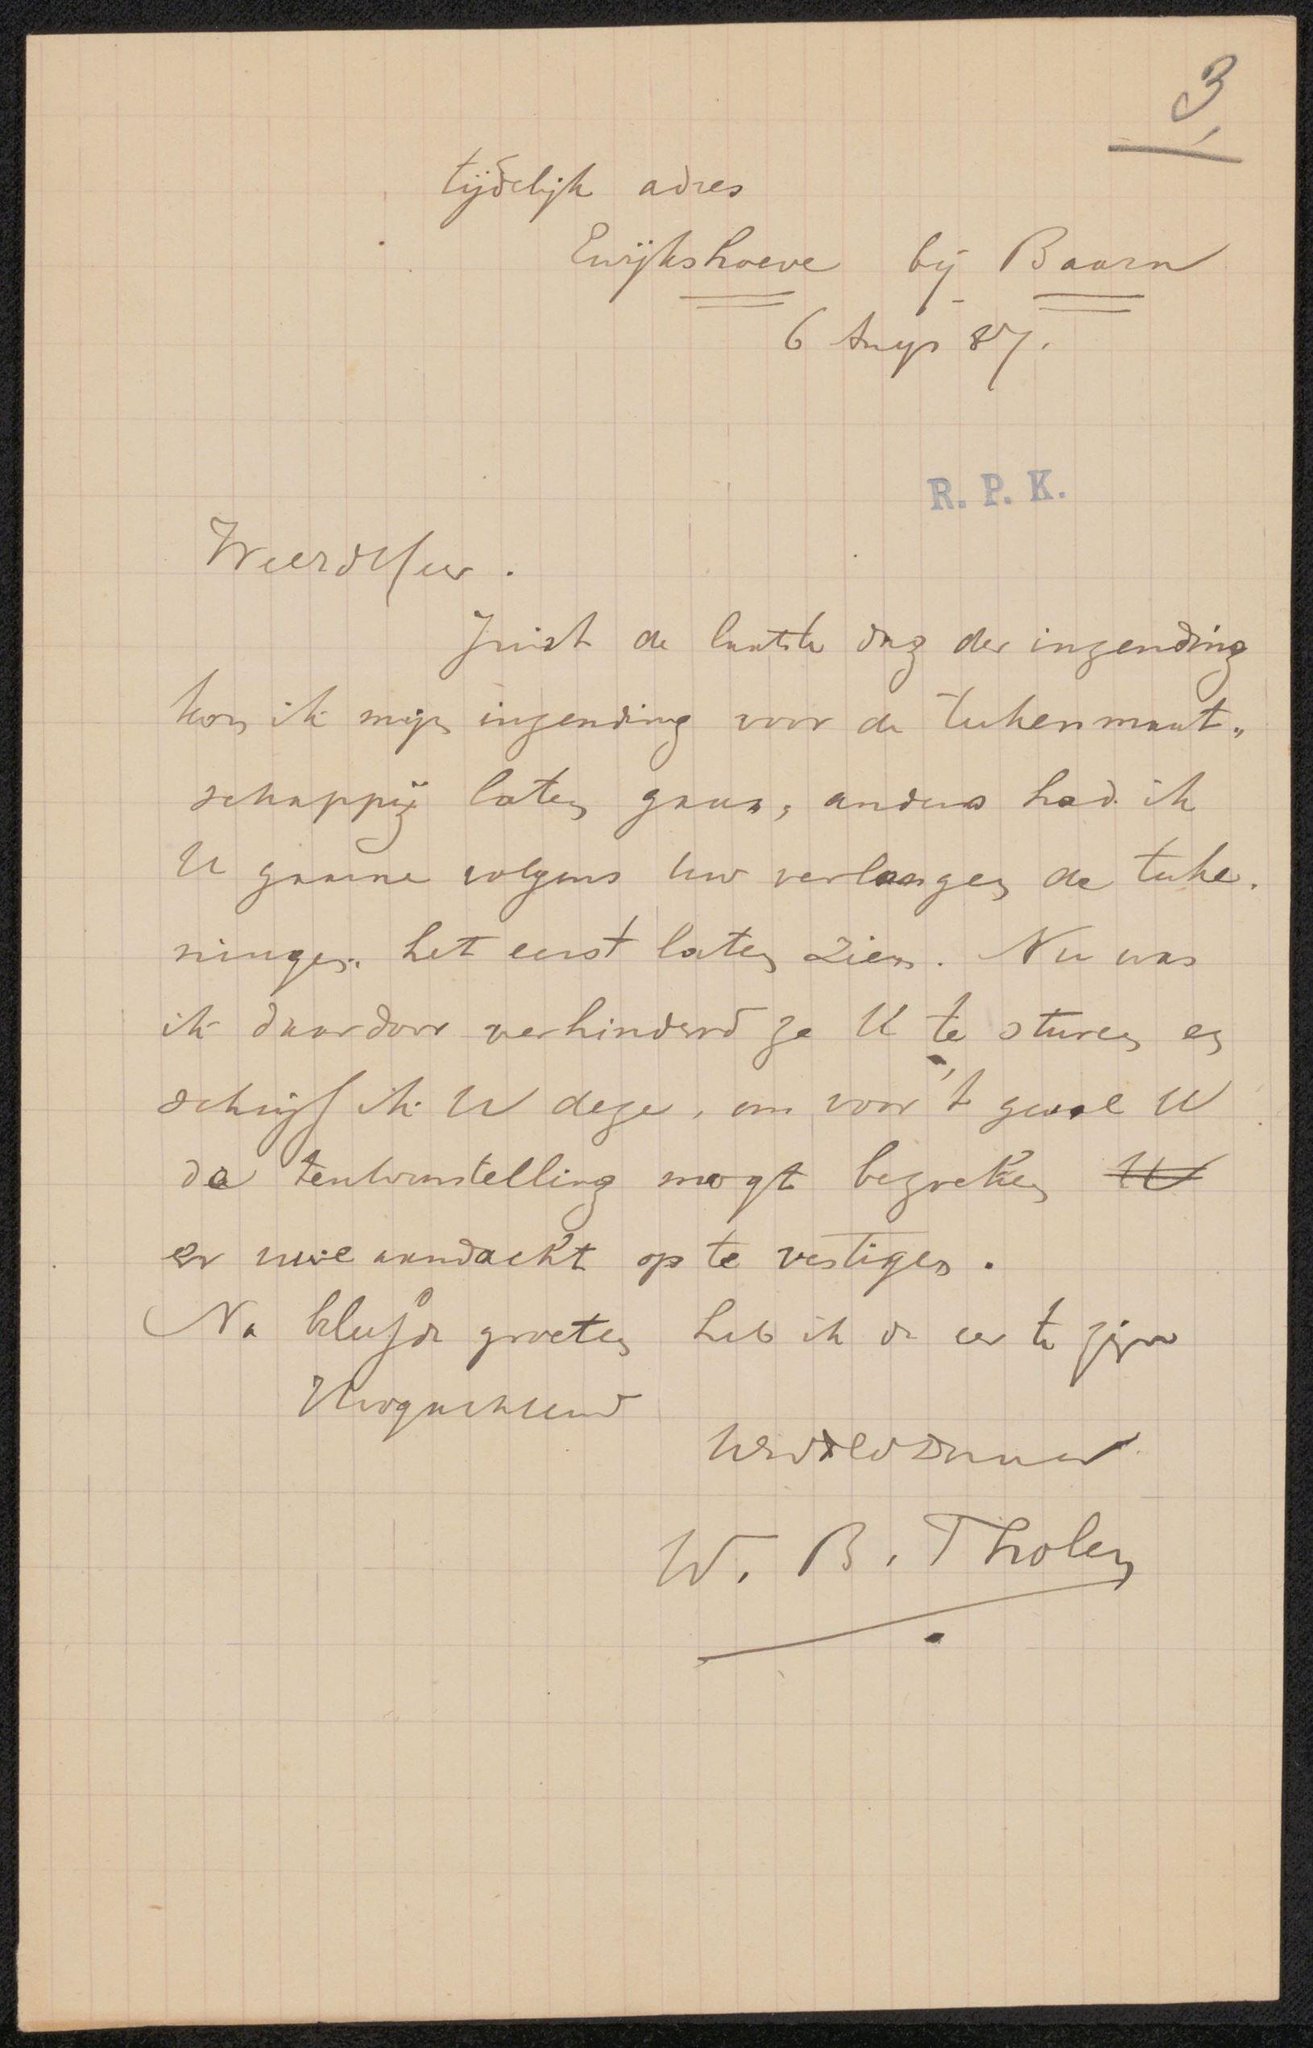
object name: letter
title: Brief aan Frans Buffa en Zonen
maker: willem bastiaan tholen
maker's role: draughtsman, painter, print maker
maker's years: 1860-1931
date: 1887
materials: ink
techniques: pen, writing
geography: ewijkshoeve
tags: drawing, exhibition ~ art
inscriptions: collector's mark: Lugt 2233